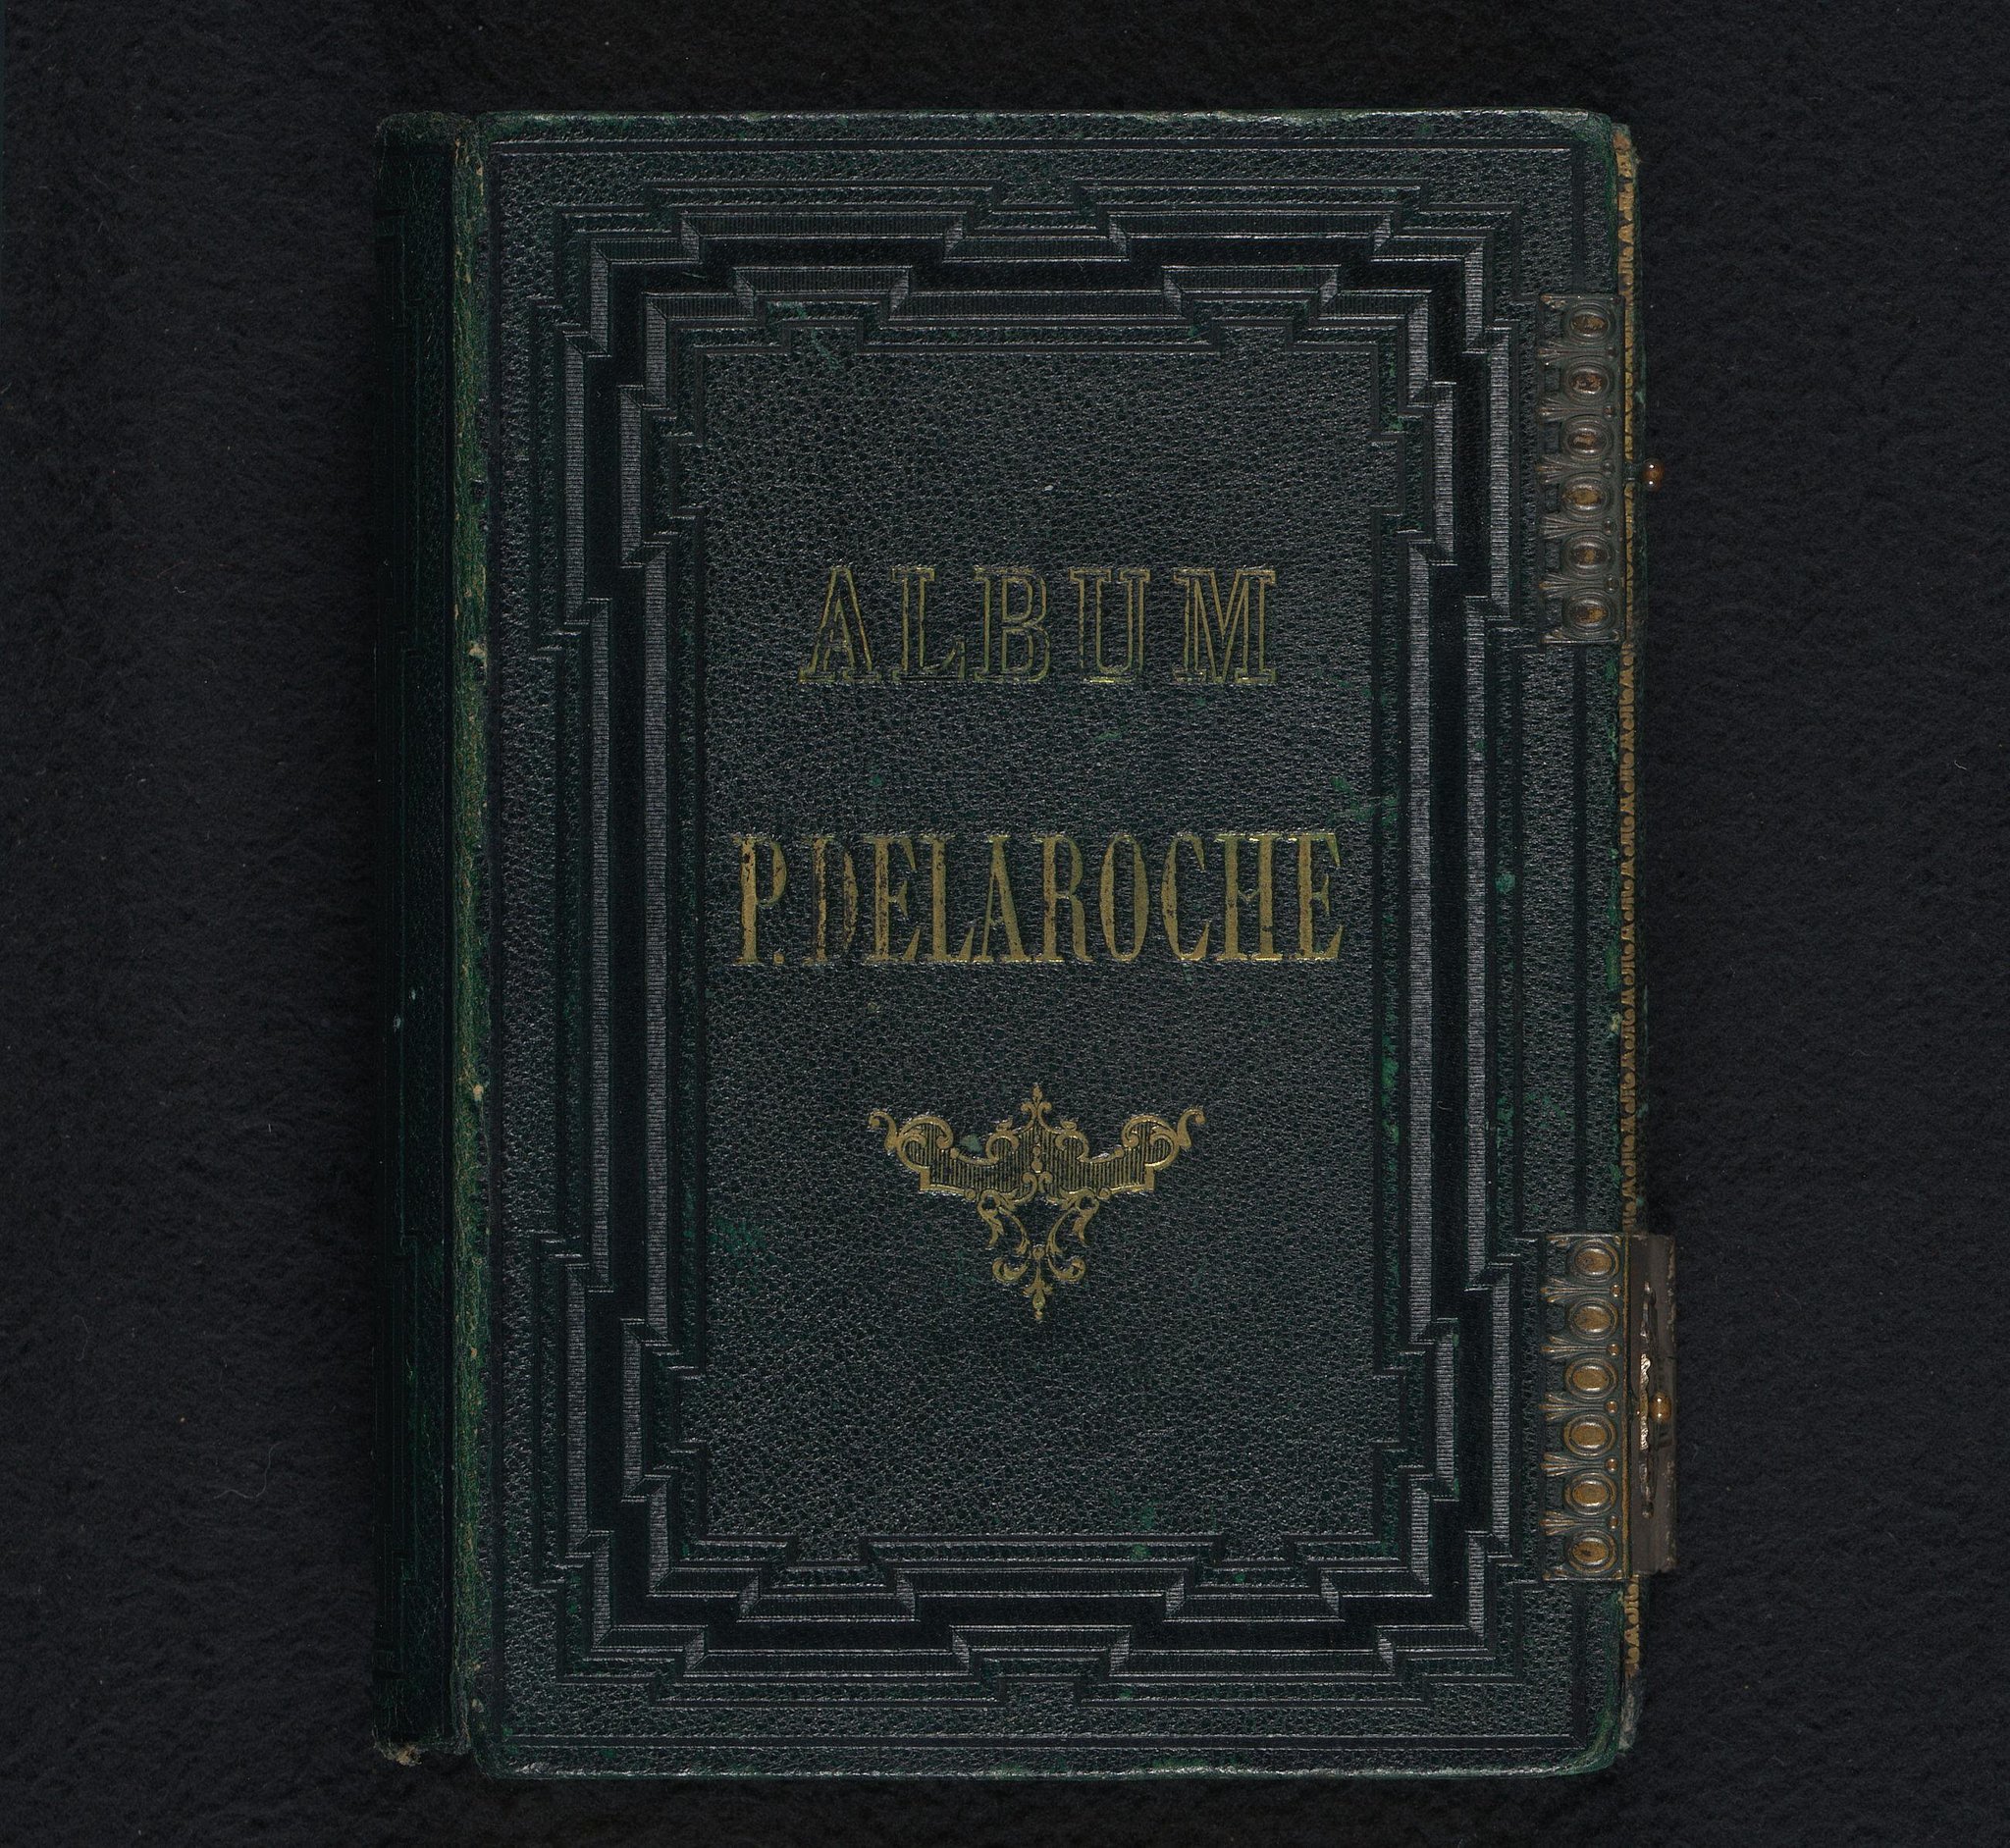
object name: slip in album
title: Frans fotoalbum met dertig fotoreproducties van schilderijen en een portret van Paul Delaroche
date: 1870-1890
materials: cardboard, leather, metal, paper, photographic support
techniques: albumen print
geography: paris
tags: london, napoleon i (emperor of the french), historical persons, queen, christ, picture, painting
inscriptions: collector's mark: ‘DIENST/ VERSPREIDE/ RIJKSKOLLEKTIES/ (...) A 767’, number: ‘f 55,-’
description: Fotoalbum met dertig pagina's met op iedere pagina een carte-de-visite in met gepreegde rand omkaderde passe-partout. Afgebeeld zijn 29 fotoreproducties van schilderijen van Paul Delaroche en een fotoreproductie van een getekend portret van de schilder. Alle foto's zijn gemaakt door de Franse firma Goupil & Cie en het album is ook door deze vervaardiger samengesteld en uitgegeven.